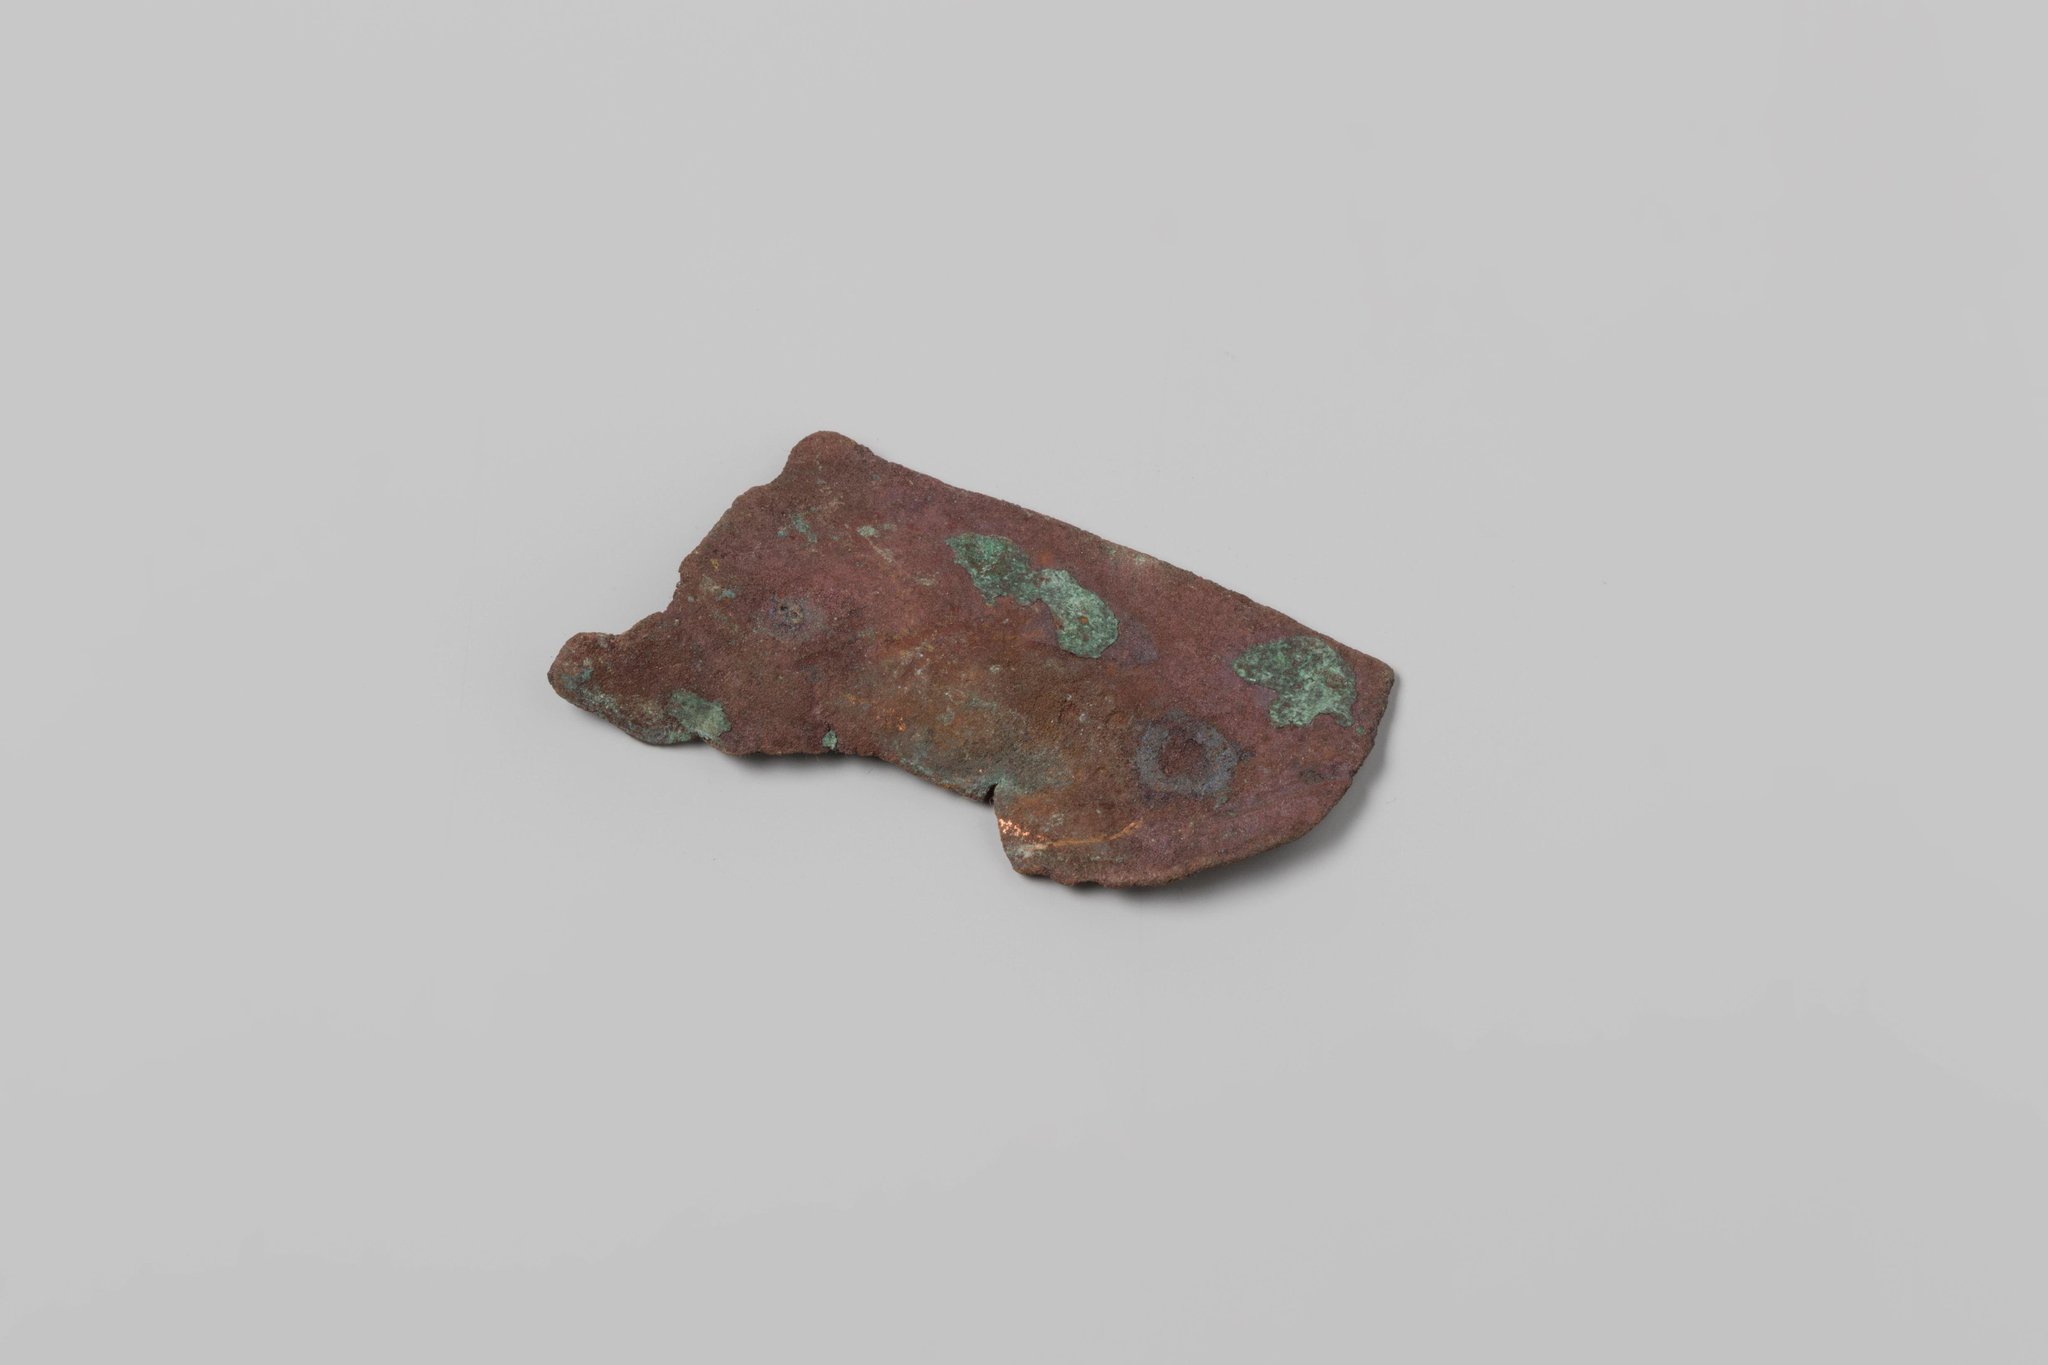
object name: fragment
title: Fragment koper uit het wrak van de Oost-Indiëvaarder Hollandia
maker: Anonymous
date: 1700-1743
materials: copper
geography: netherlands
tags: verenigde oostindische compagnie, hollandia (schip), annet